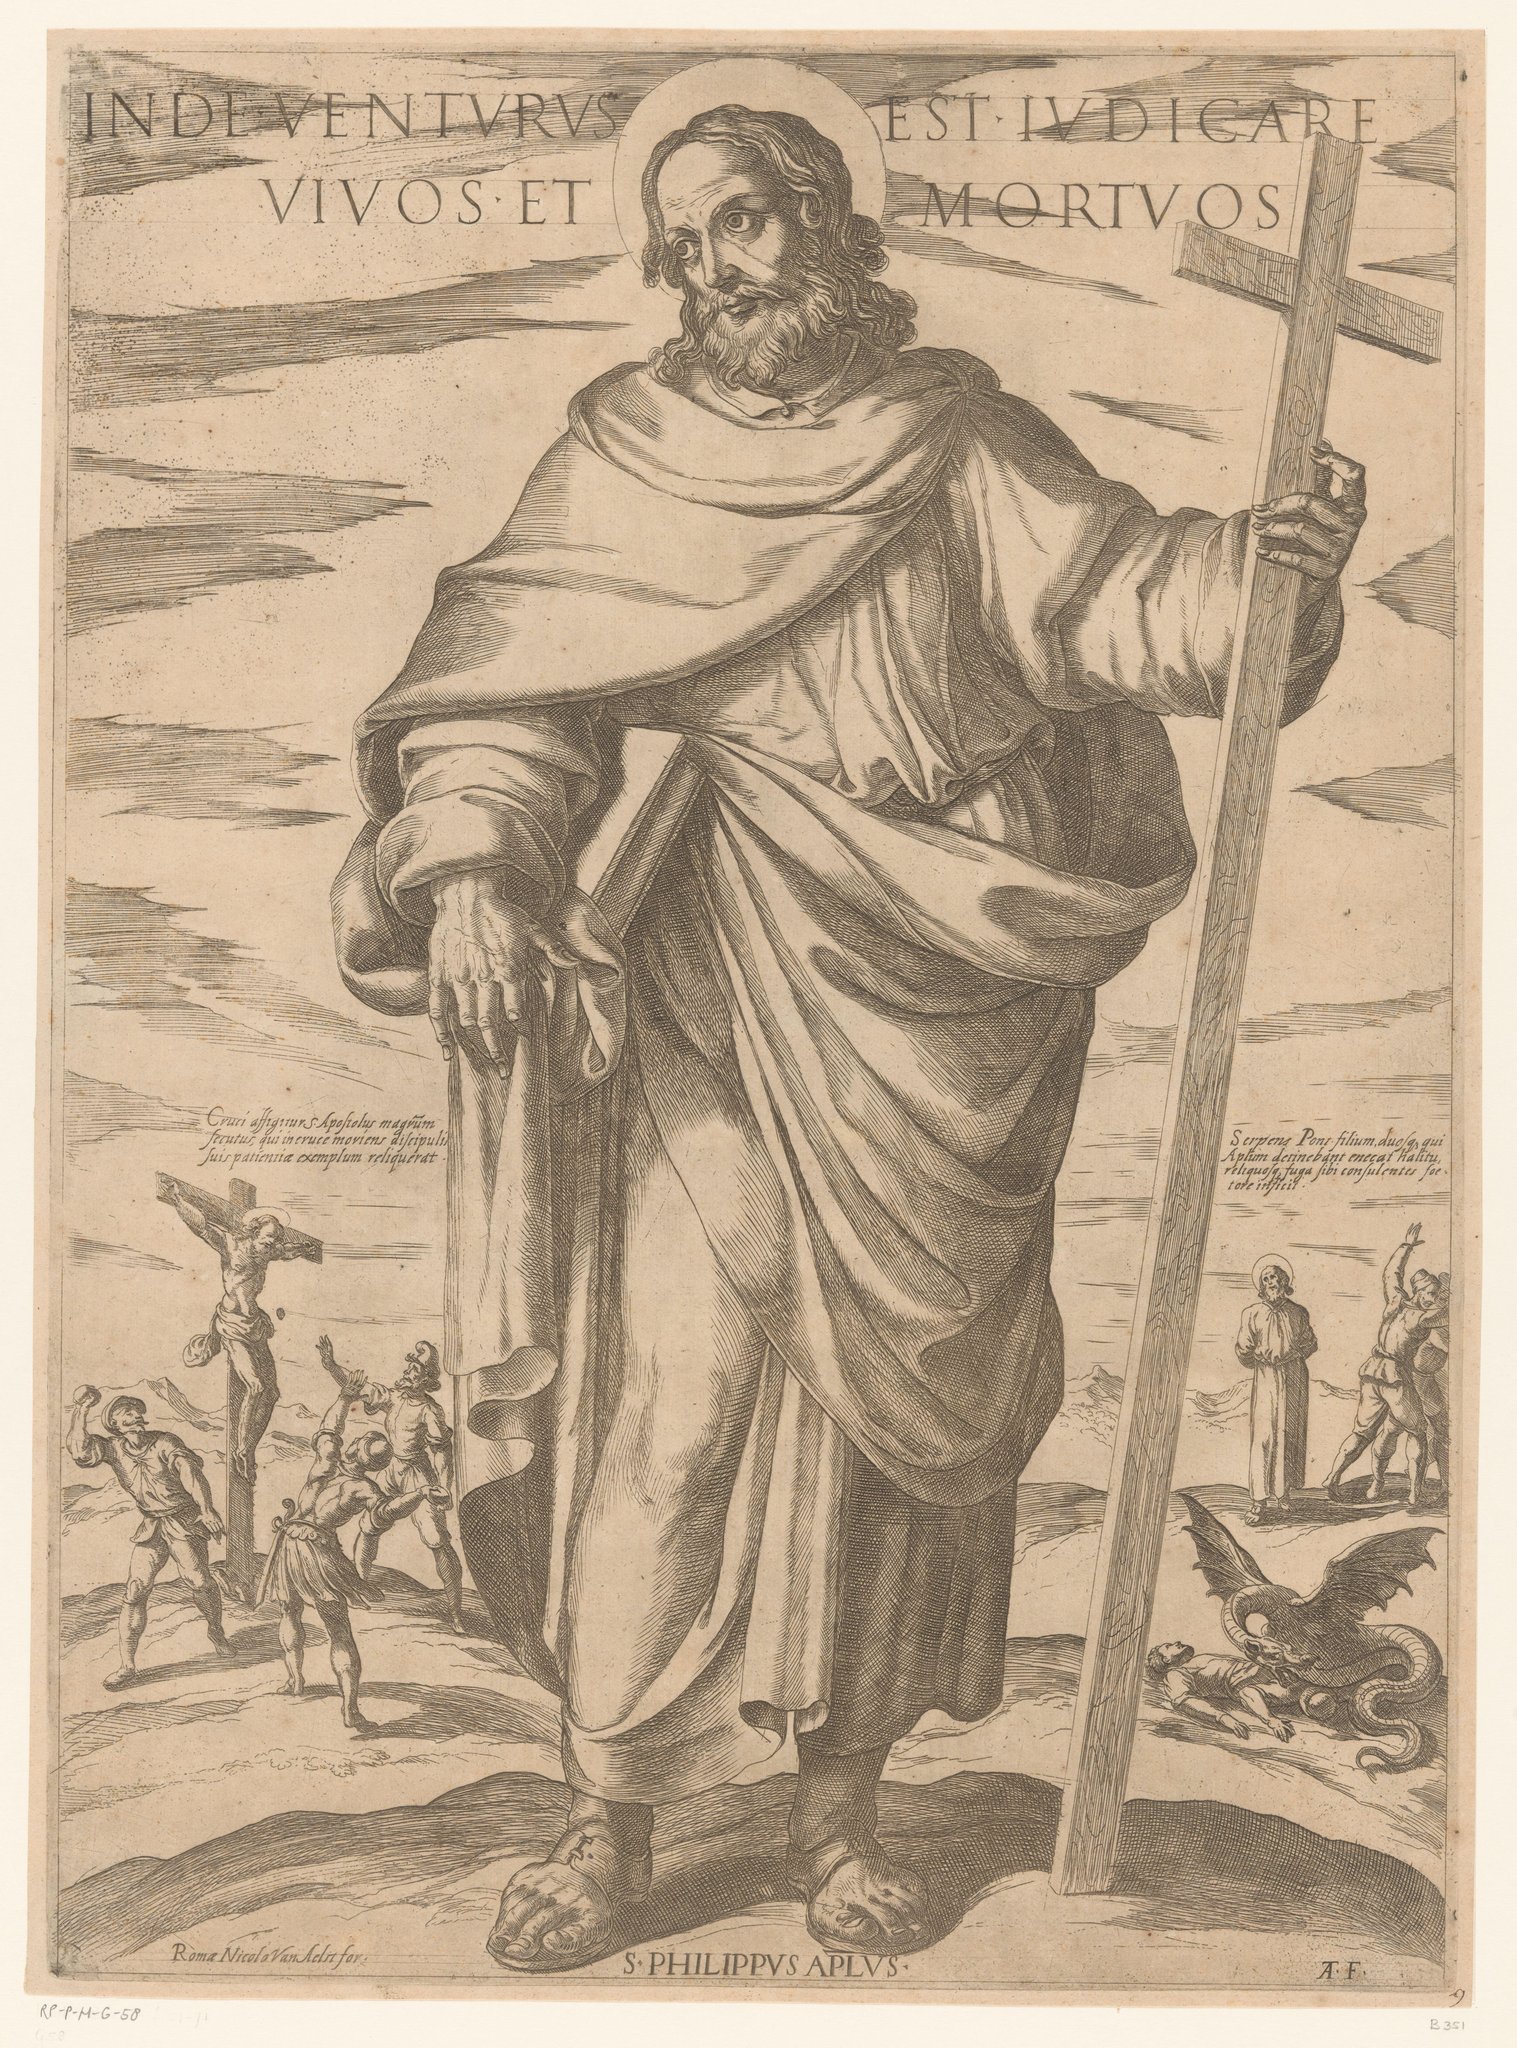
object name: print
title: Christus, Maria en de apostelen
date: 1565-1630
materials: paper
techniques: etching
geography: italy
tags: the apostle philip; possible attributes: book, cross, dish with snake, lance, scroll, stone, sword, while hanging on the cross philip is stoned, the dragon kills the son of the priest and two tribunes; bystanders get ill of the fumes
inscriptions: collector's mark: Lugt 11, number: ‘9’, collector's mark: ‘Hinloopen’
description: De heilige Filippus met kruis en boek. Op de achtergrond links wordt Filippus gekruisigd en gestenigd. Op de achtergrond rechts een draak die een tegenstander van Filippus doodt.